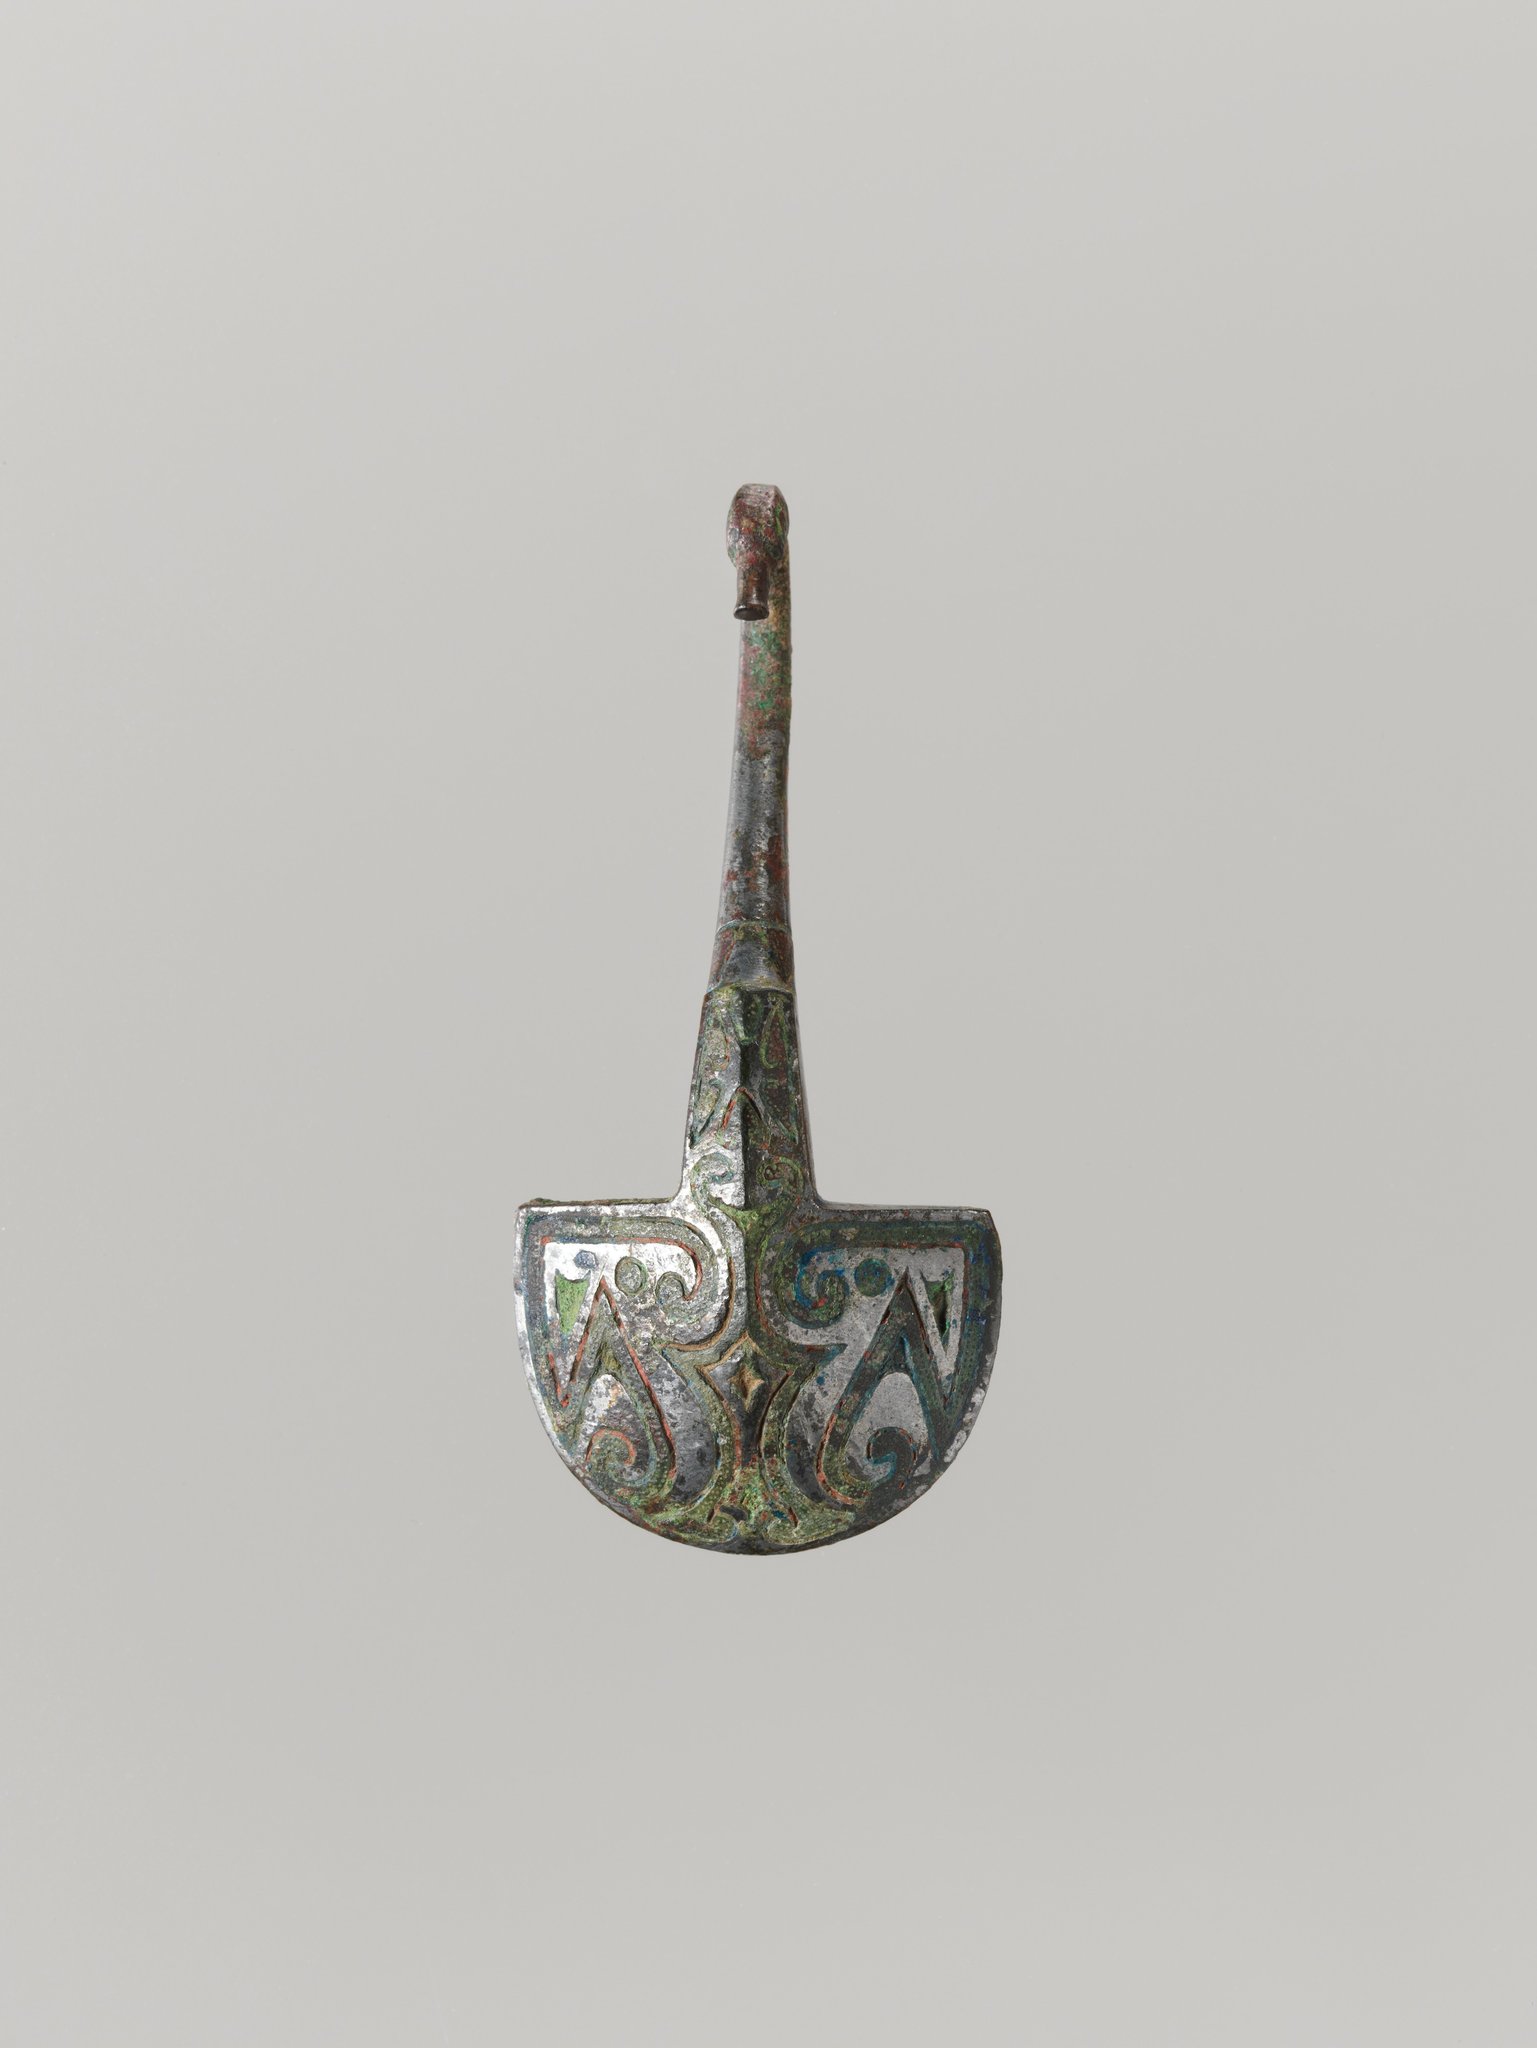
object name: buckle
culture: chinese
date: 206 BCE-9 CE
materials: bronze